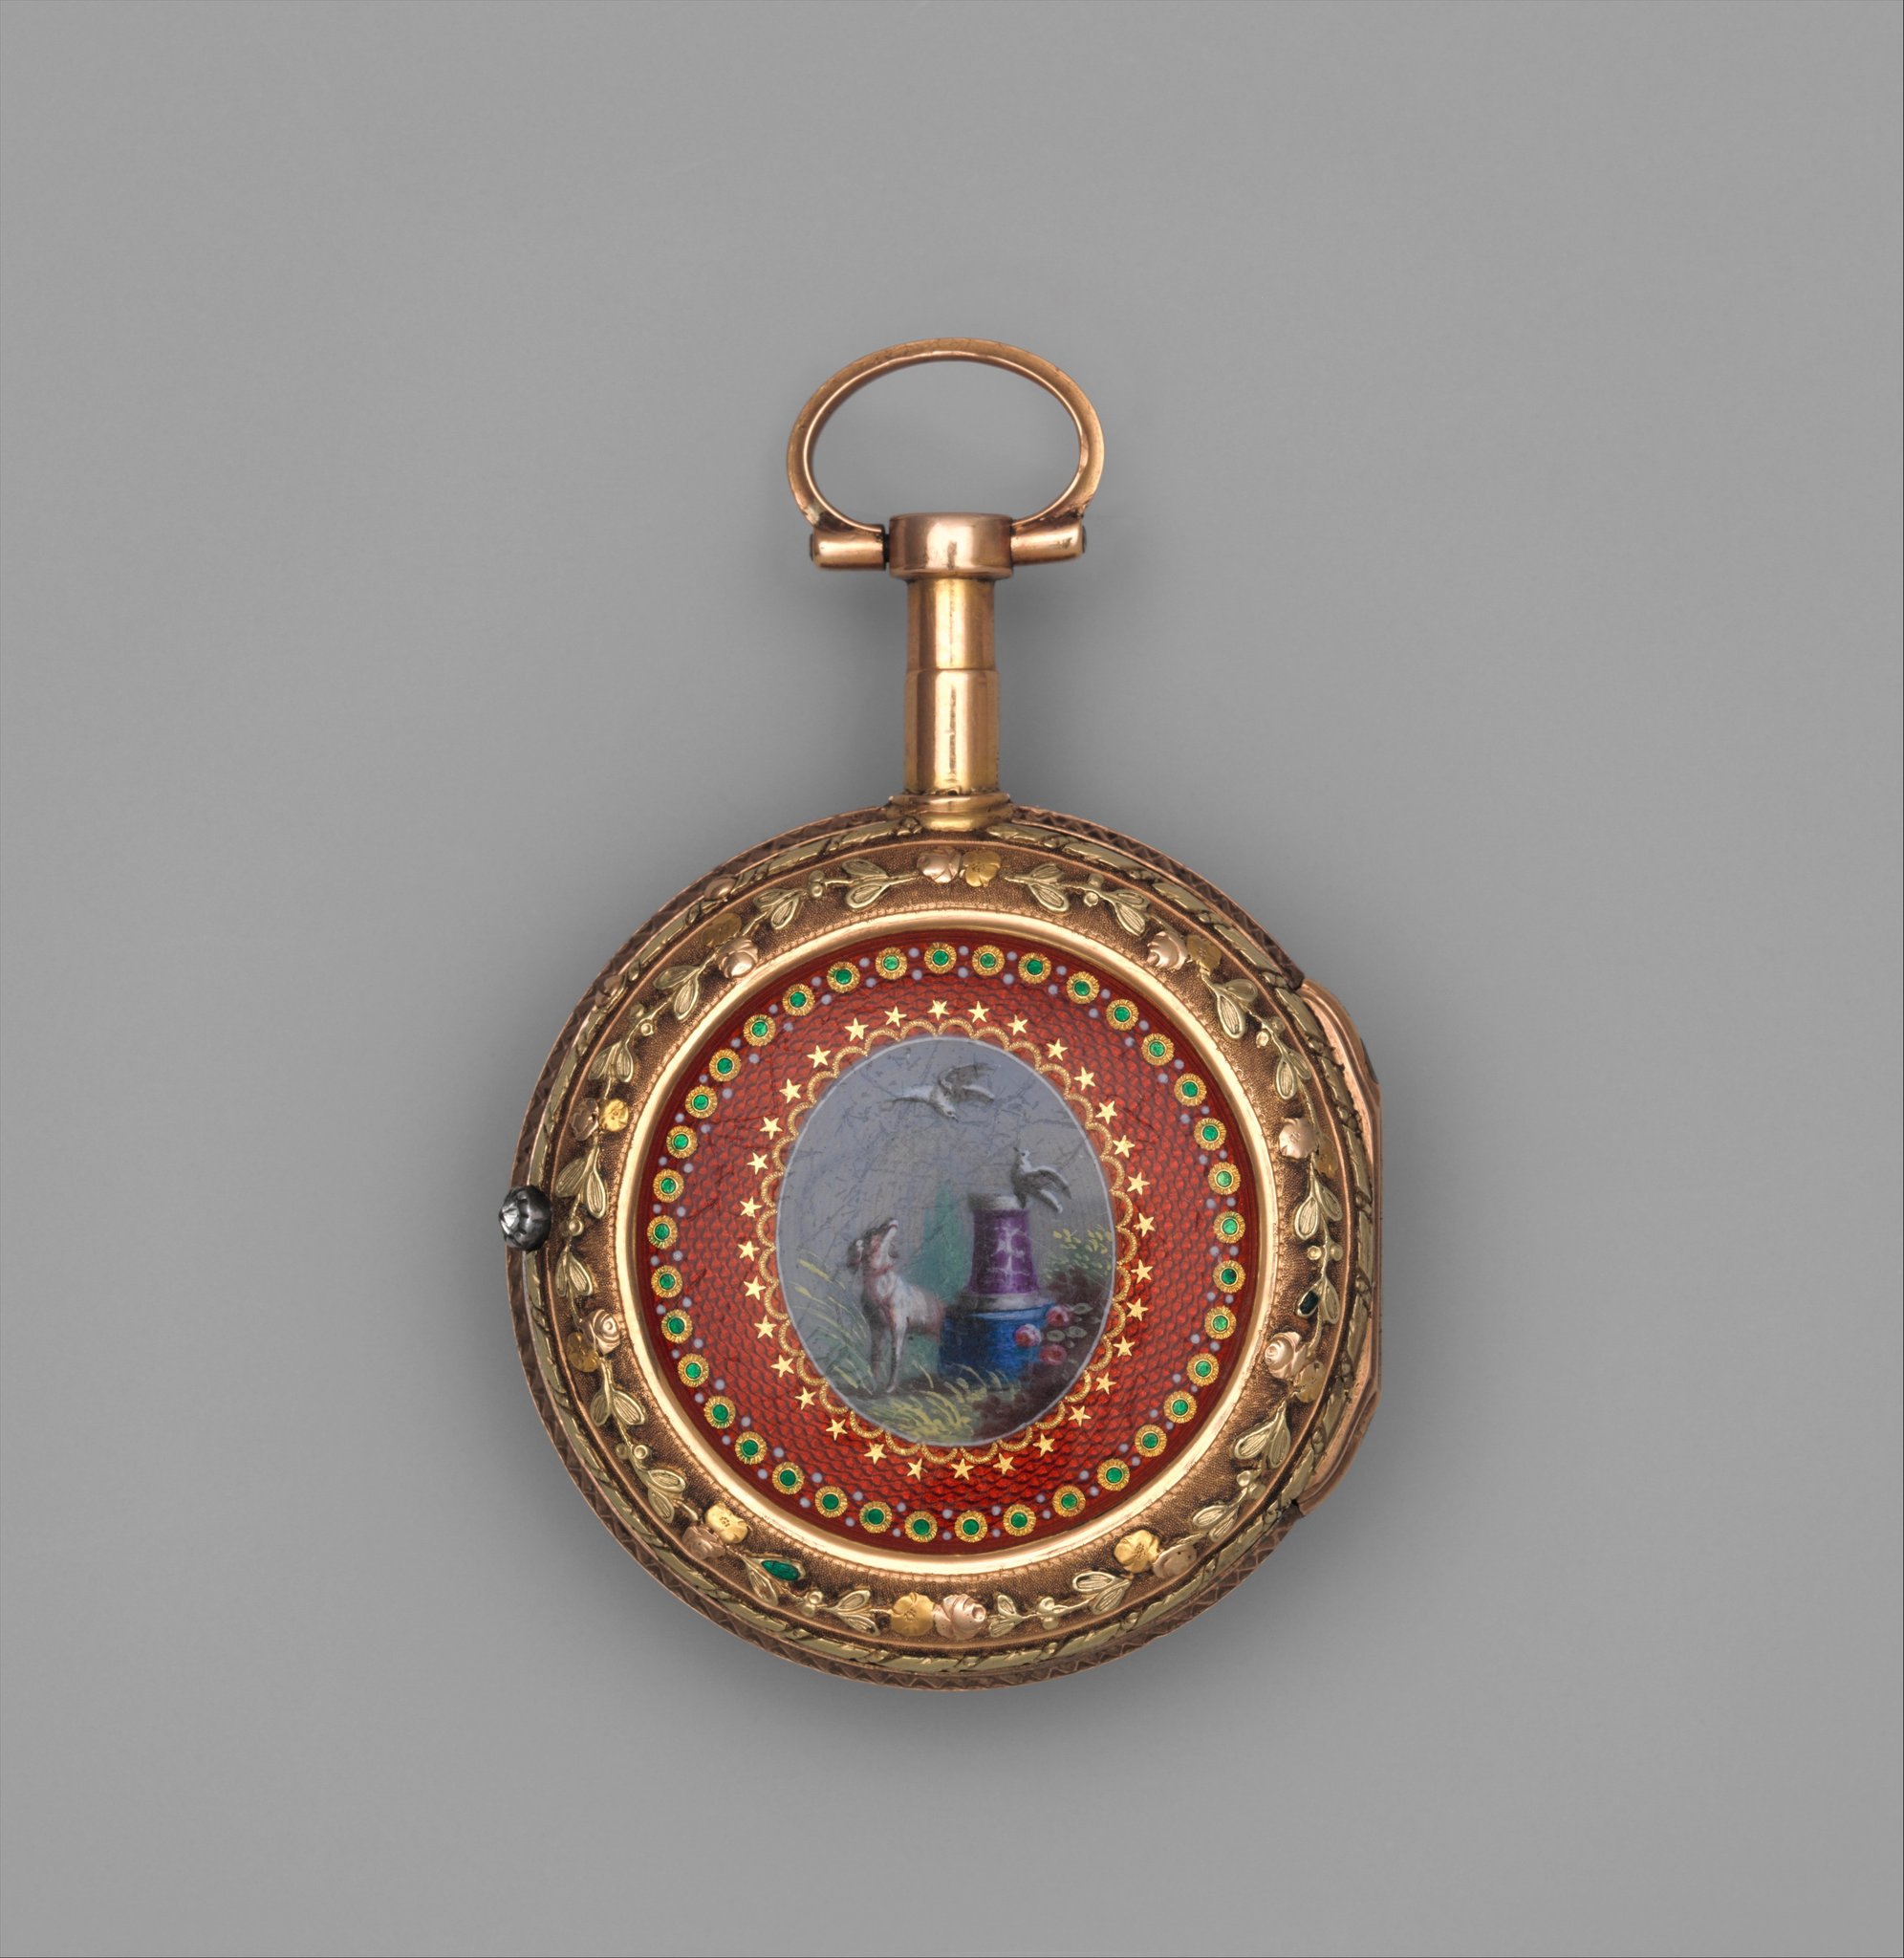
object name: calendar watch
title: Watch with calendar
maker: firm of bordier frères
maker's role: maker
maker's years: 1820-1830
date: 1780-1790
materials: brass, enamel, gold, steel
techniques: enamel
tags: birds,dogs